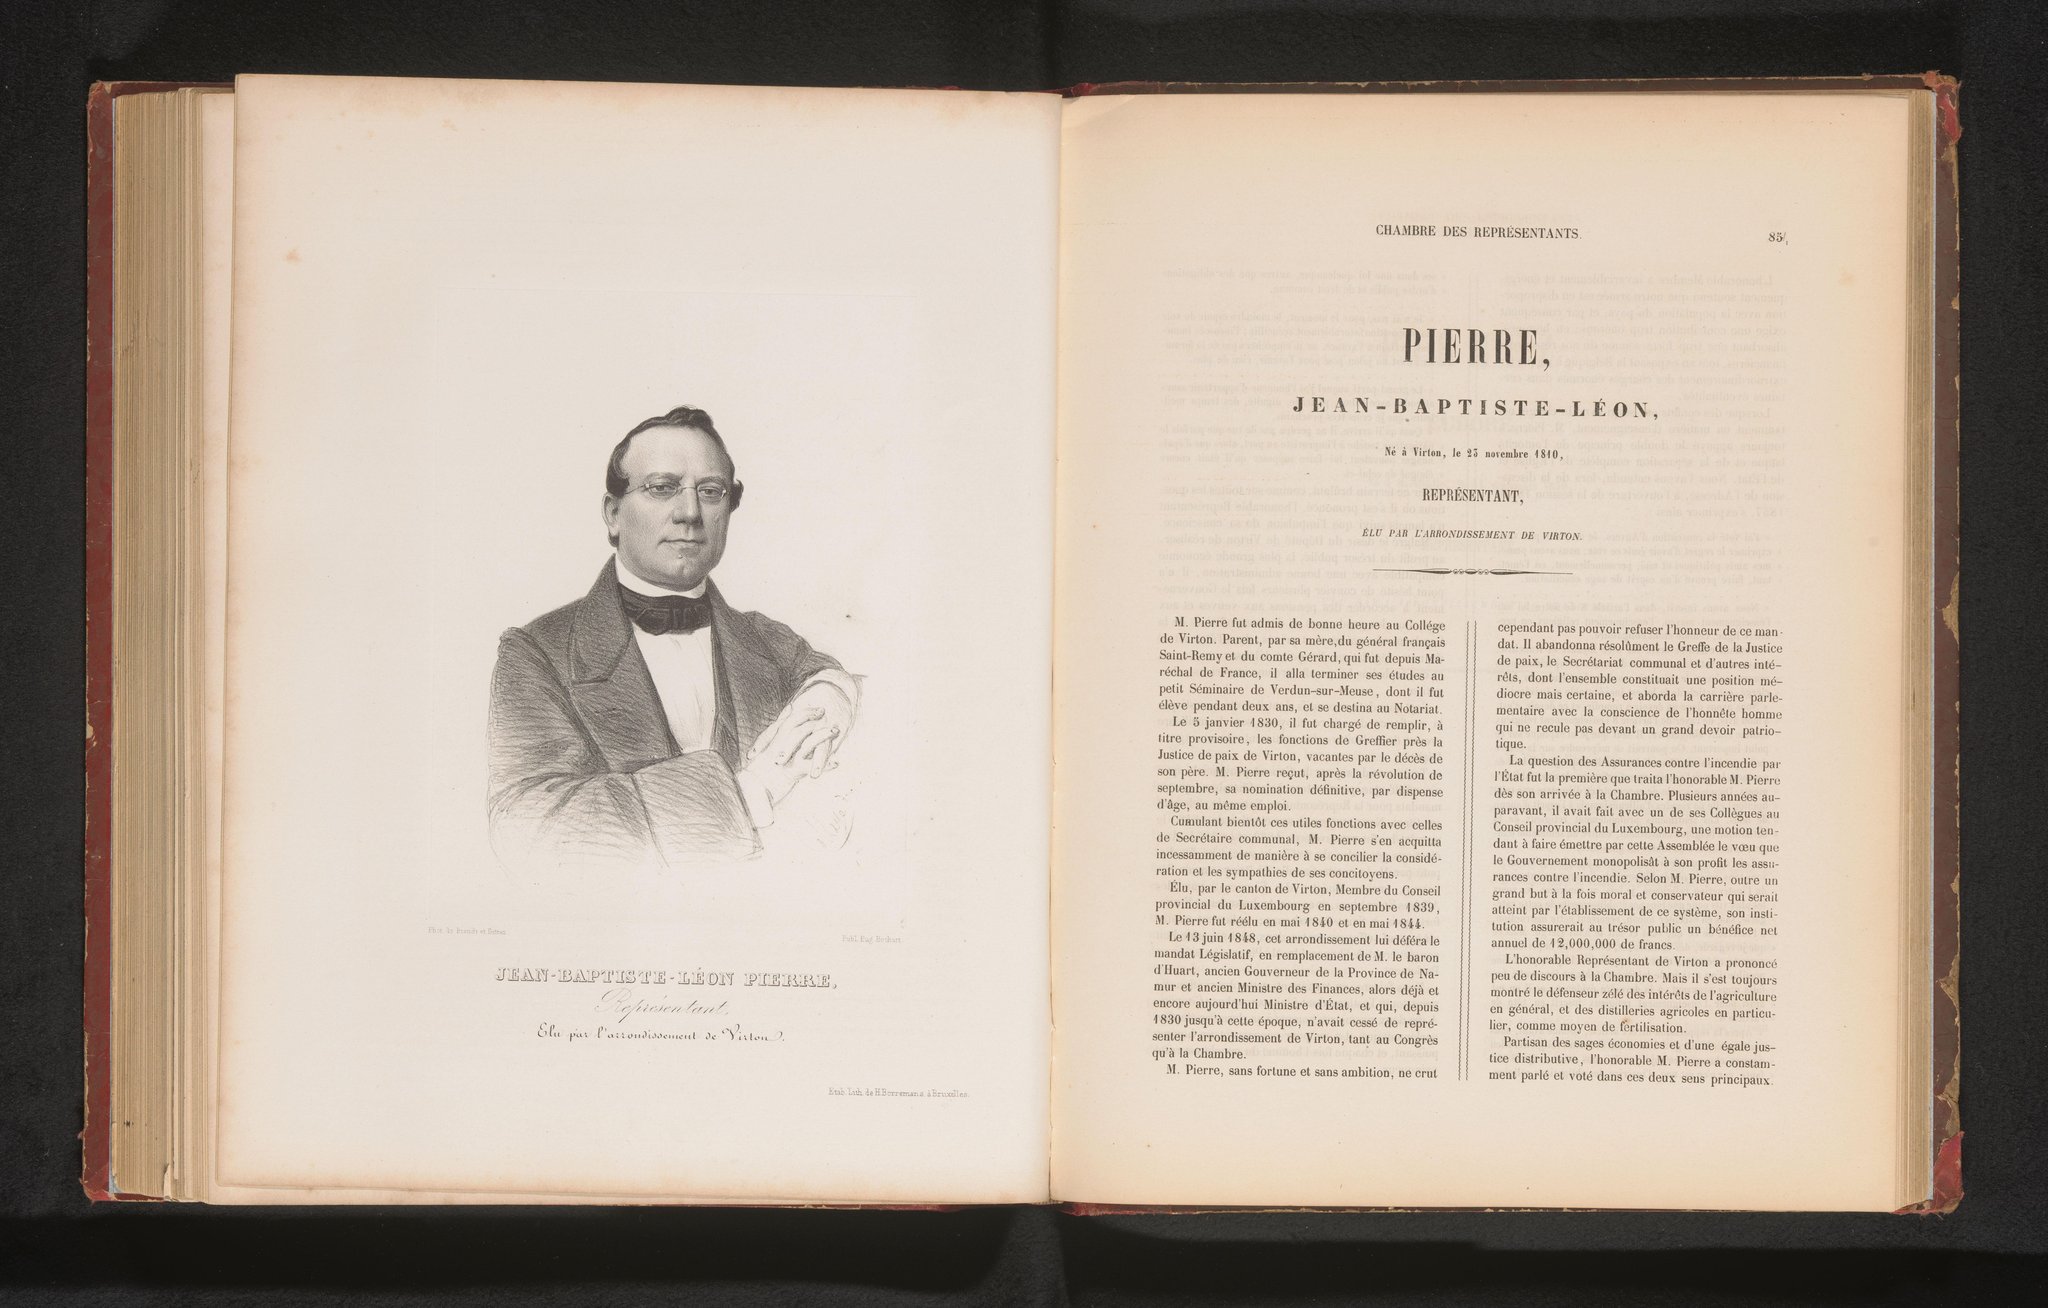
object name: print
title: Jean-Baptiste-Léon Pierre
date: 1853-1858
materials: paper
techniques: lithograph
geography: brussels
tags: politician, historical persons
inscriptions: inscription: ‘Représentant,/ Elu par l'arrondissement de Virton.’